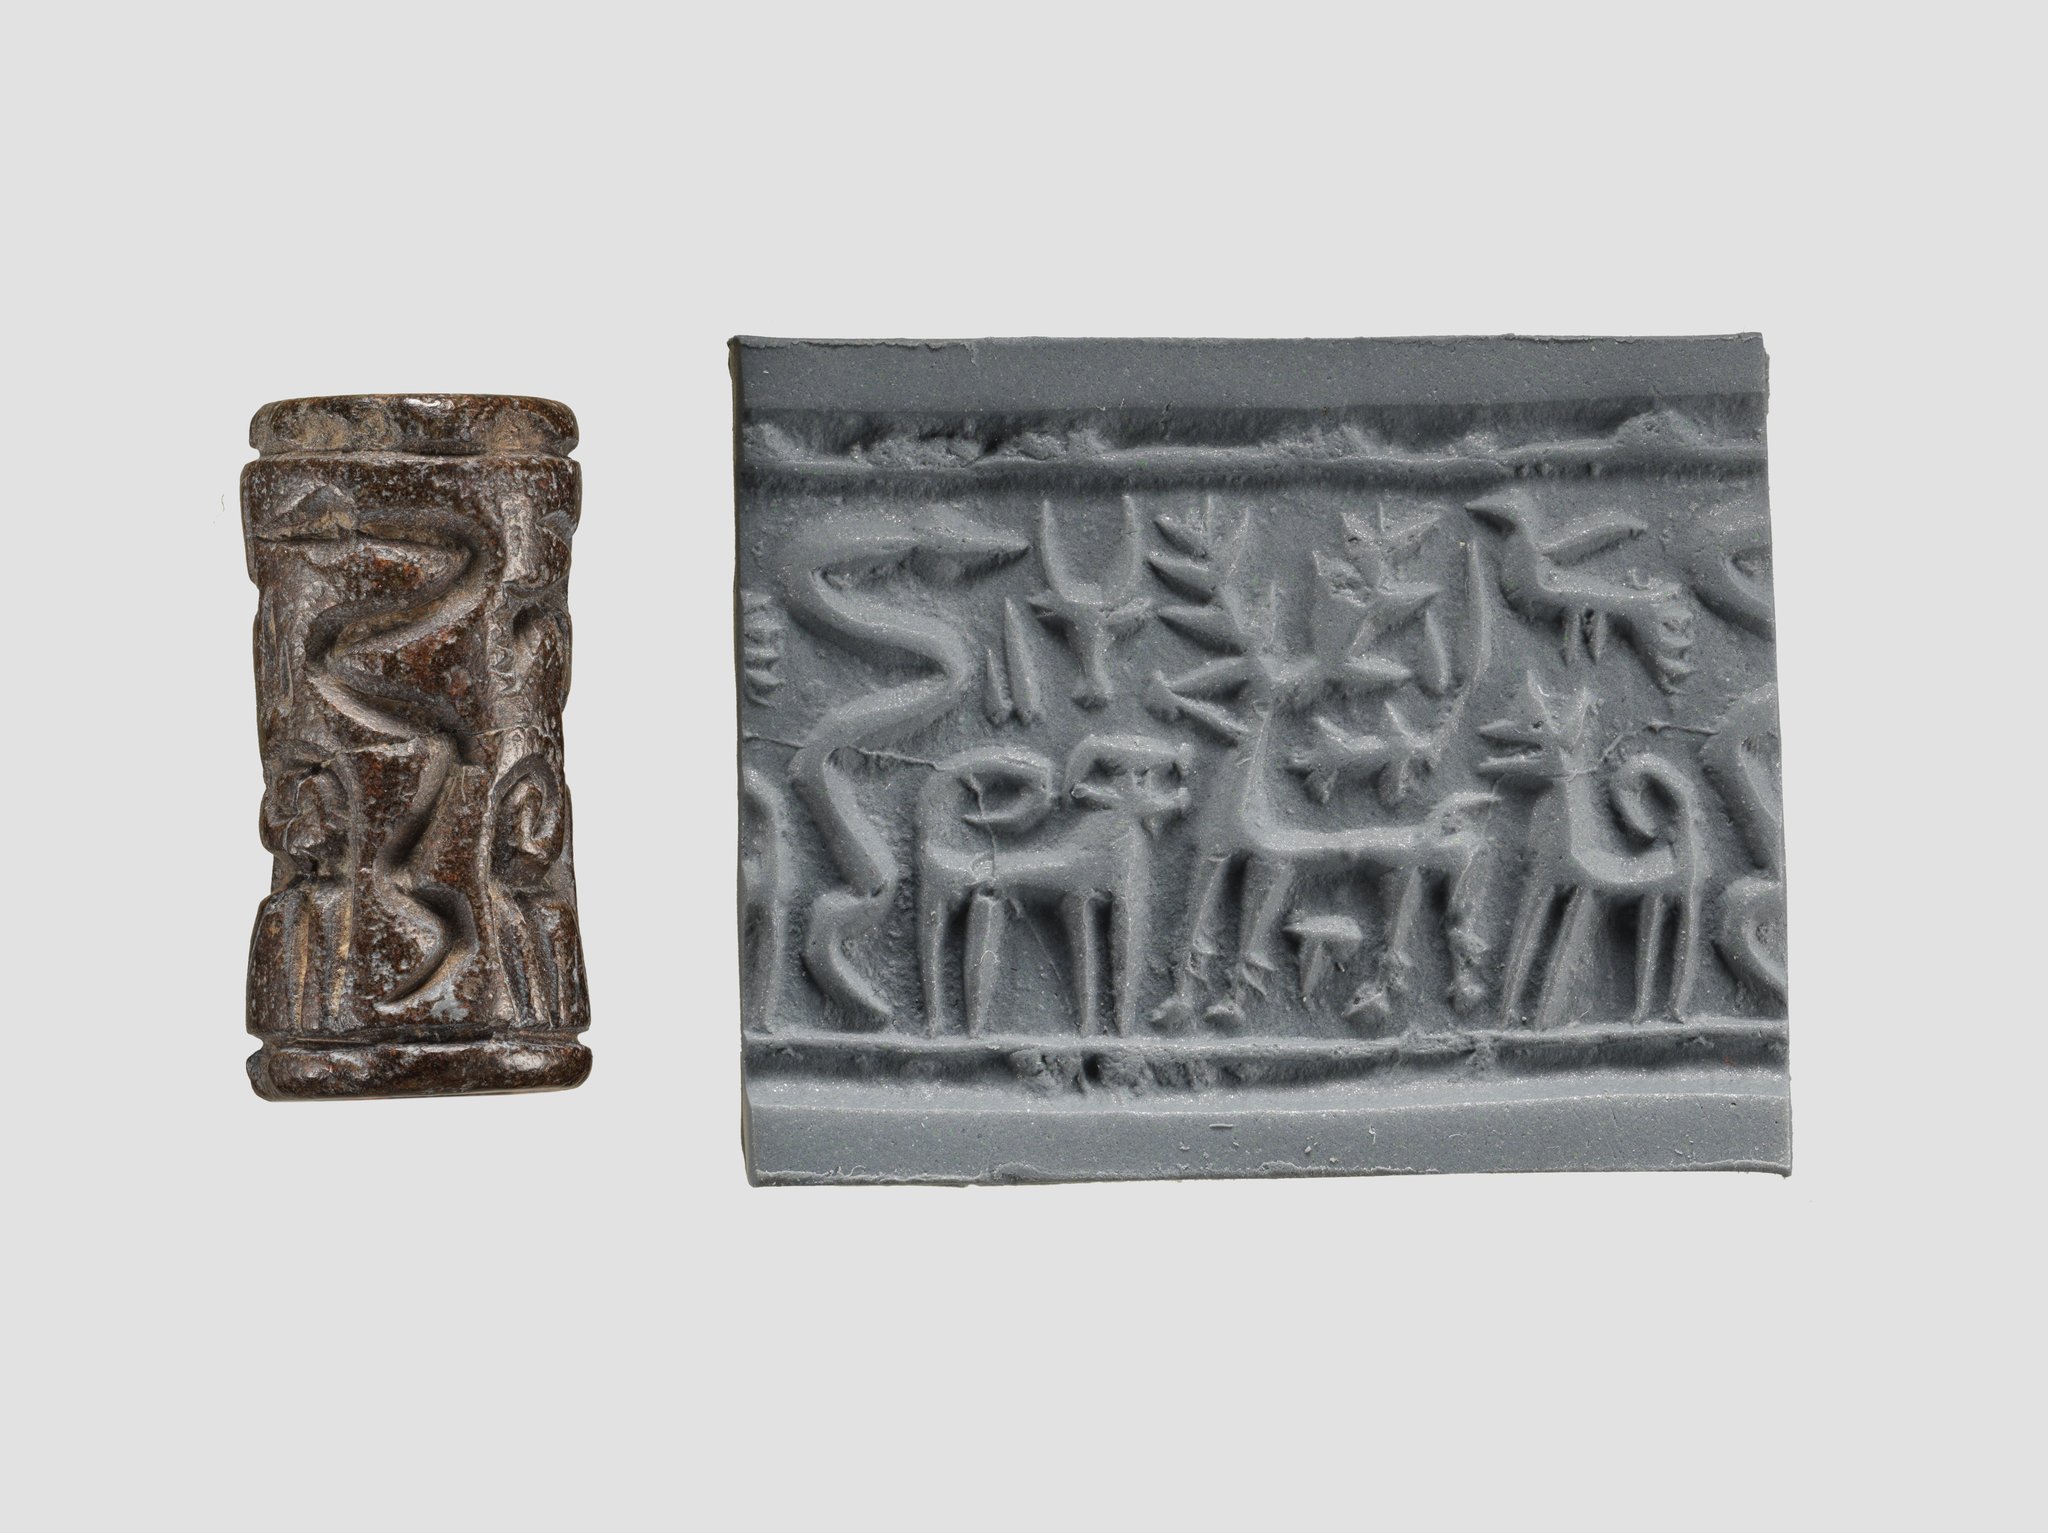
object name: cylinder seal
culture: cypriot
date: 1500-1201 BCE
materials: stone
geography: cyprus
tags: animals,birds,snakes